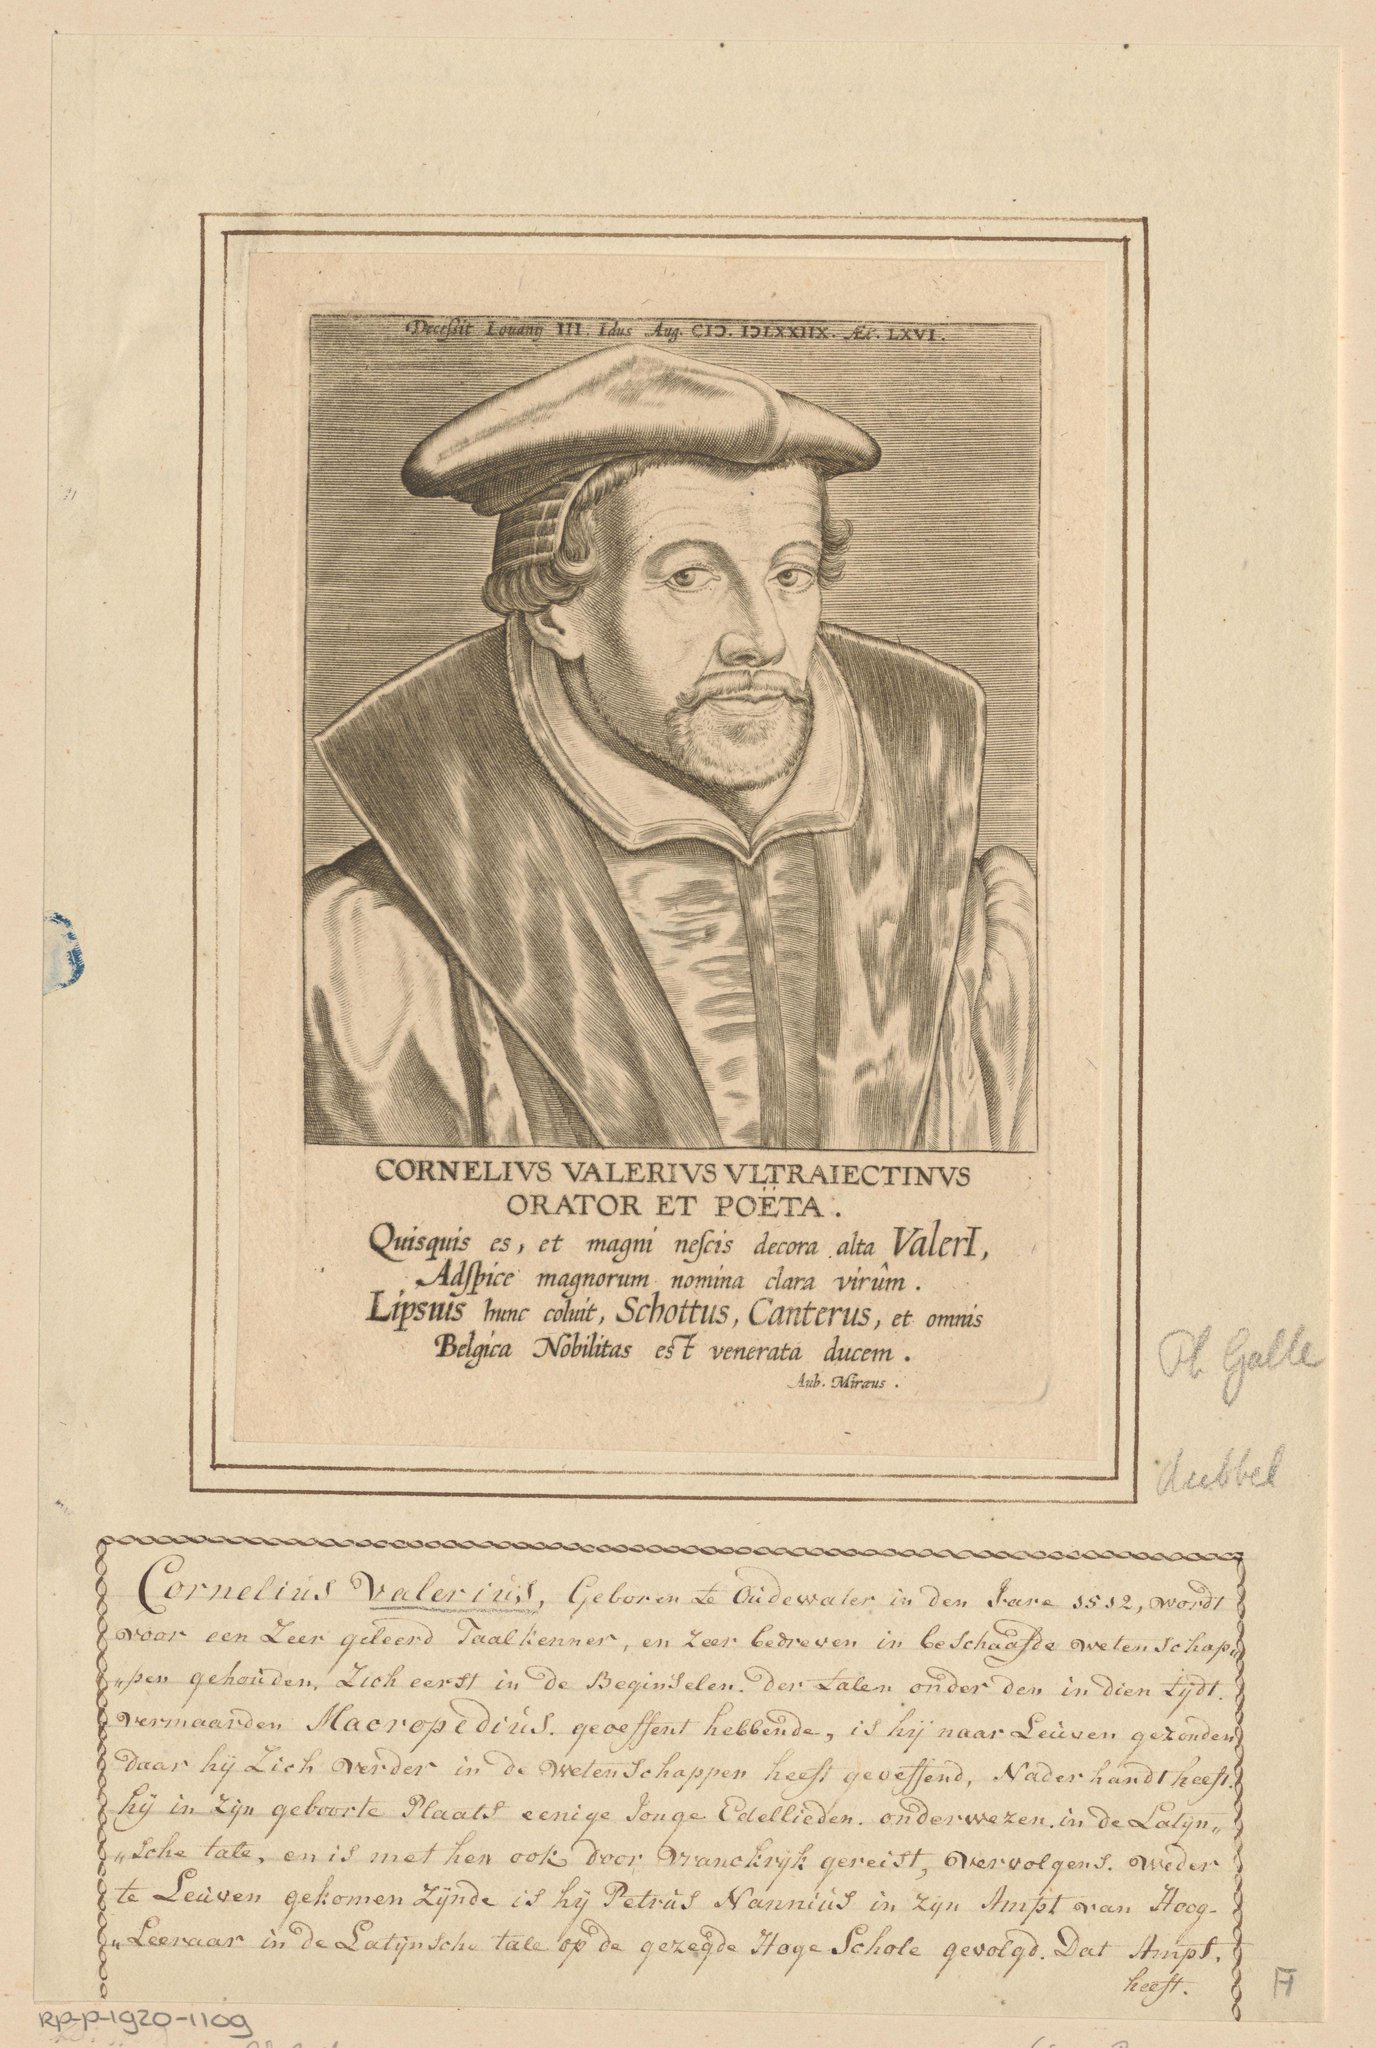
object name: print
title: Portret van Cornelis Valerius op 66-jarige leeftijd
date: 1604-1608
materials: paper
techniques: engraving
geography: antwerp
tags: louvain, cornelis valerius, historical persons, professor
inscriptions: collector's mark: Lugt 2228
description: Met een zesregelig onderschrift in het Latijn.